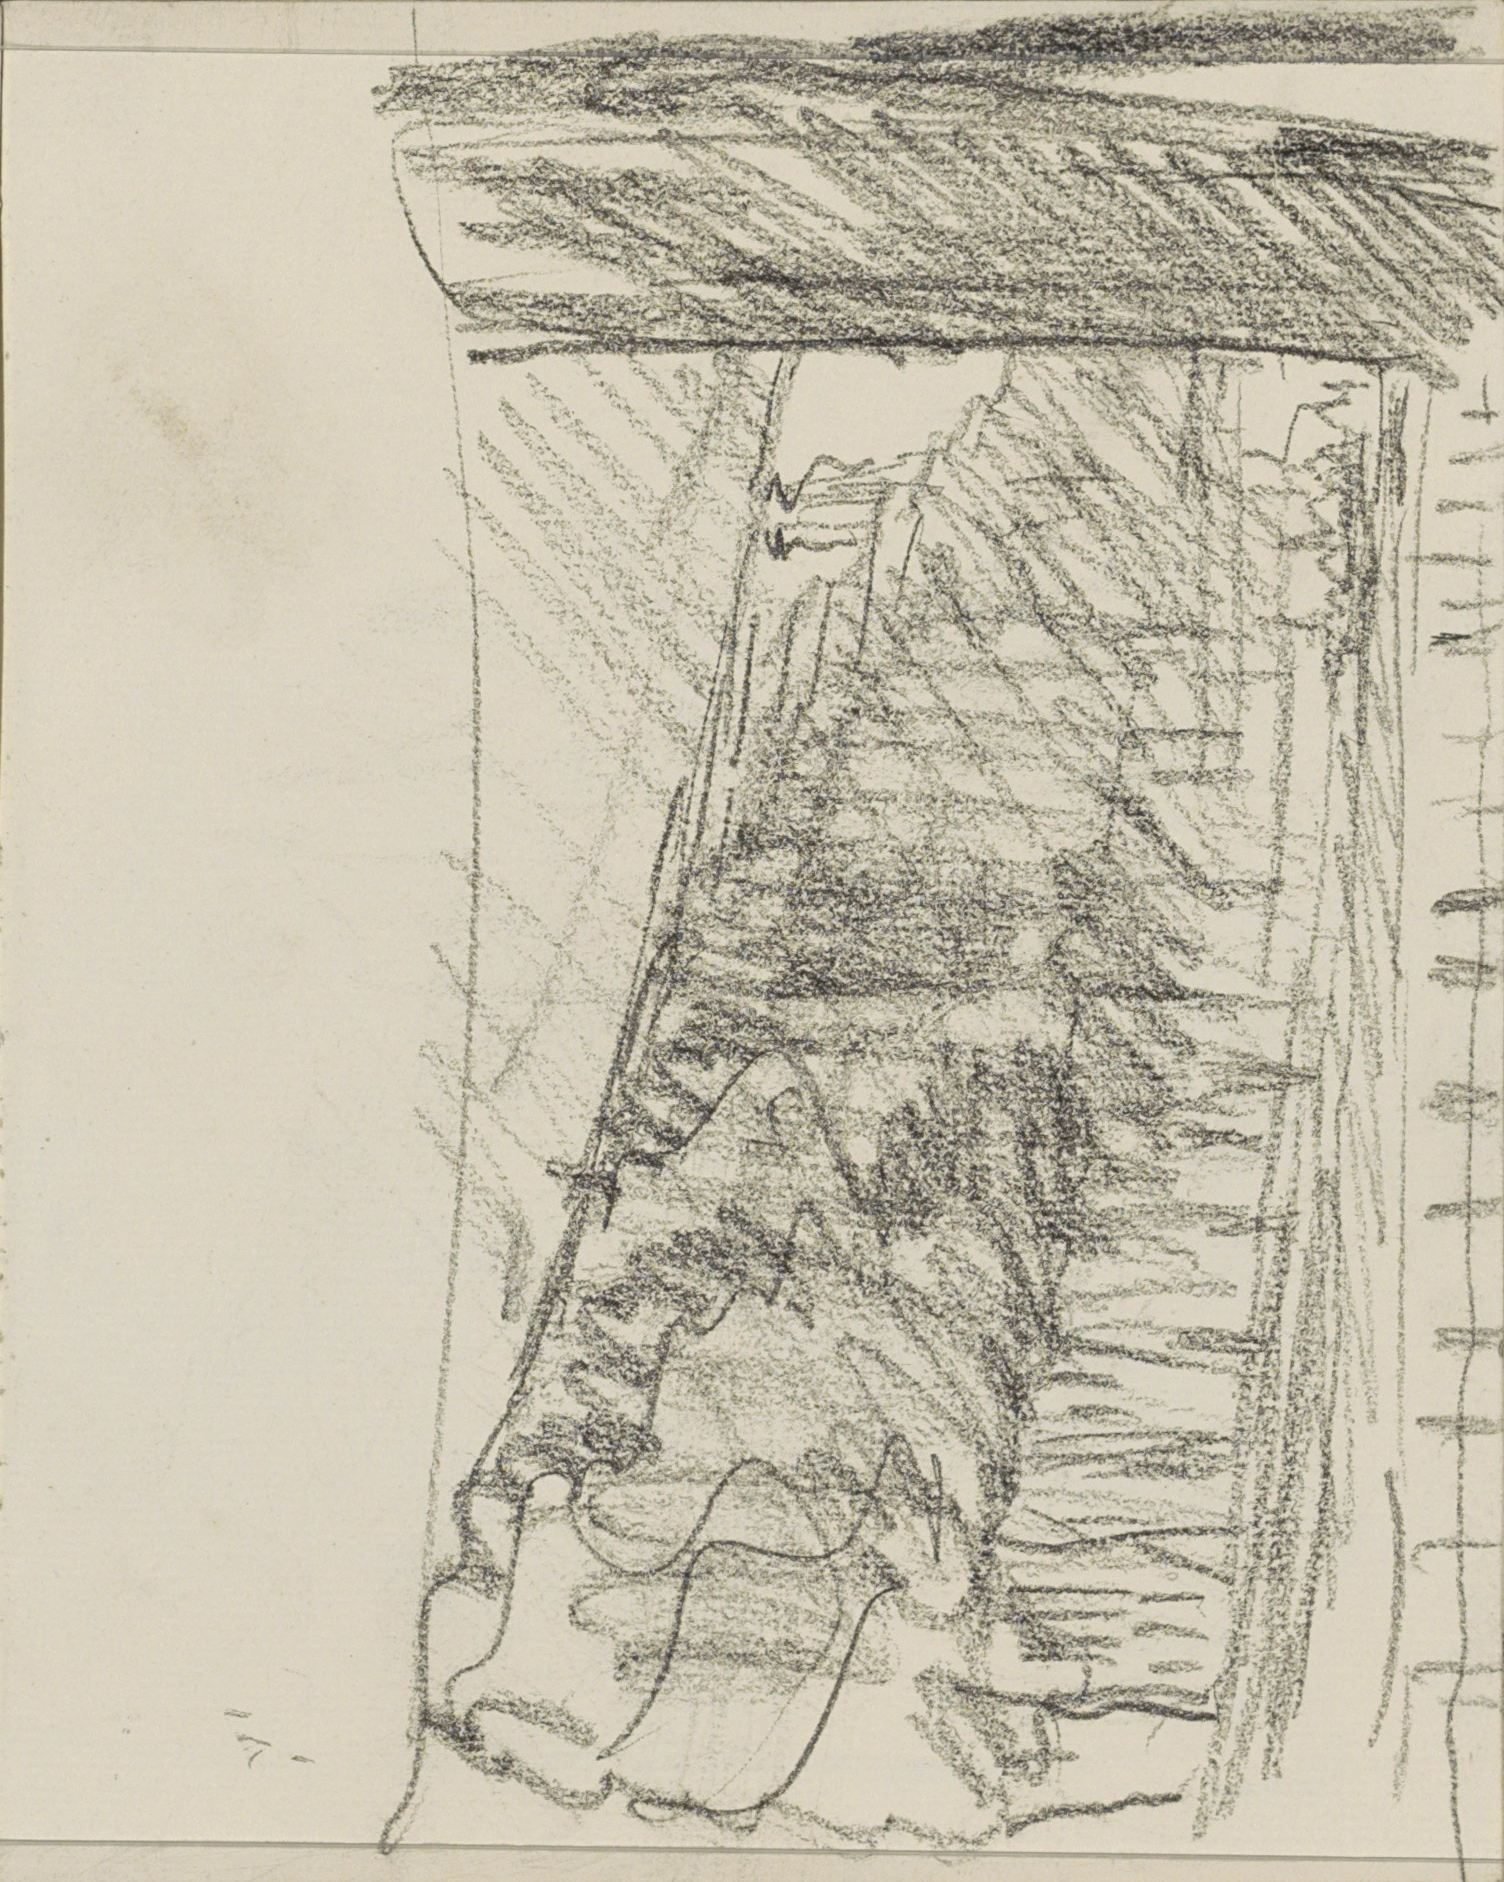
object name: sketchbook leaf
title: Bomen langs het water, mogelijk een gracht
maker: isaac israels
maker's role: draughtsman, painter, print maker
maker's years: 1865-1934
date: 1886-1903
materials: chalk, paper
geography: amsterdam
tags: canals, waters (in city)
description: Pagina 43 uit schetsboek XXXII met 92 pagina's.